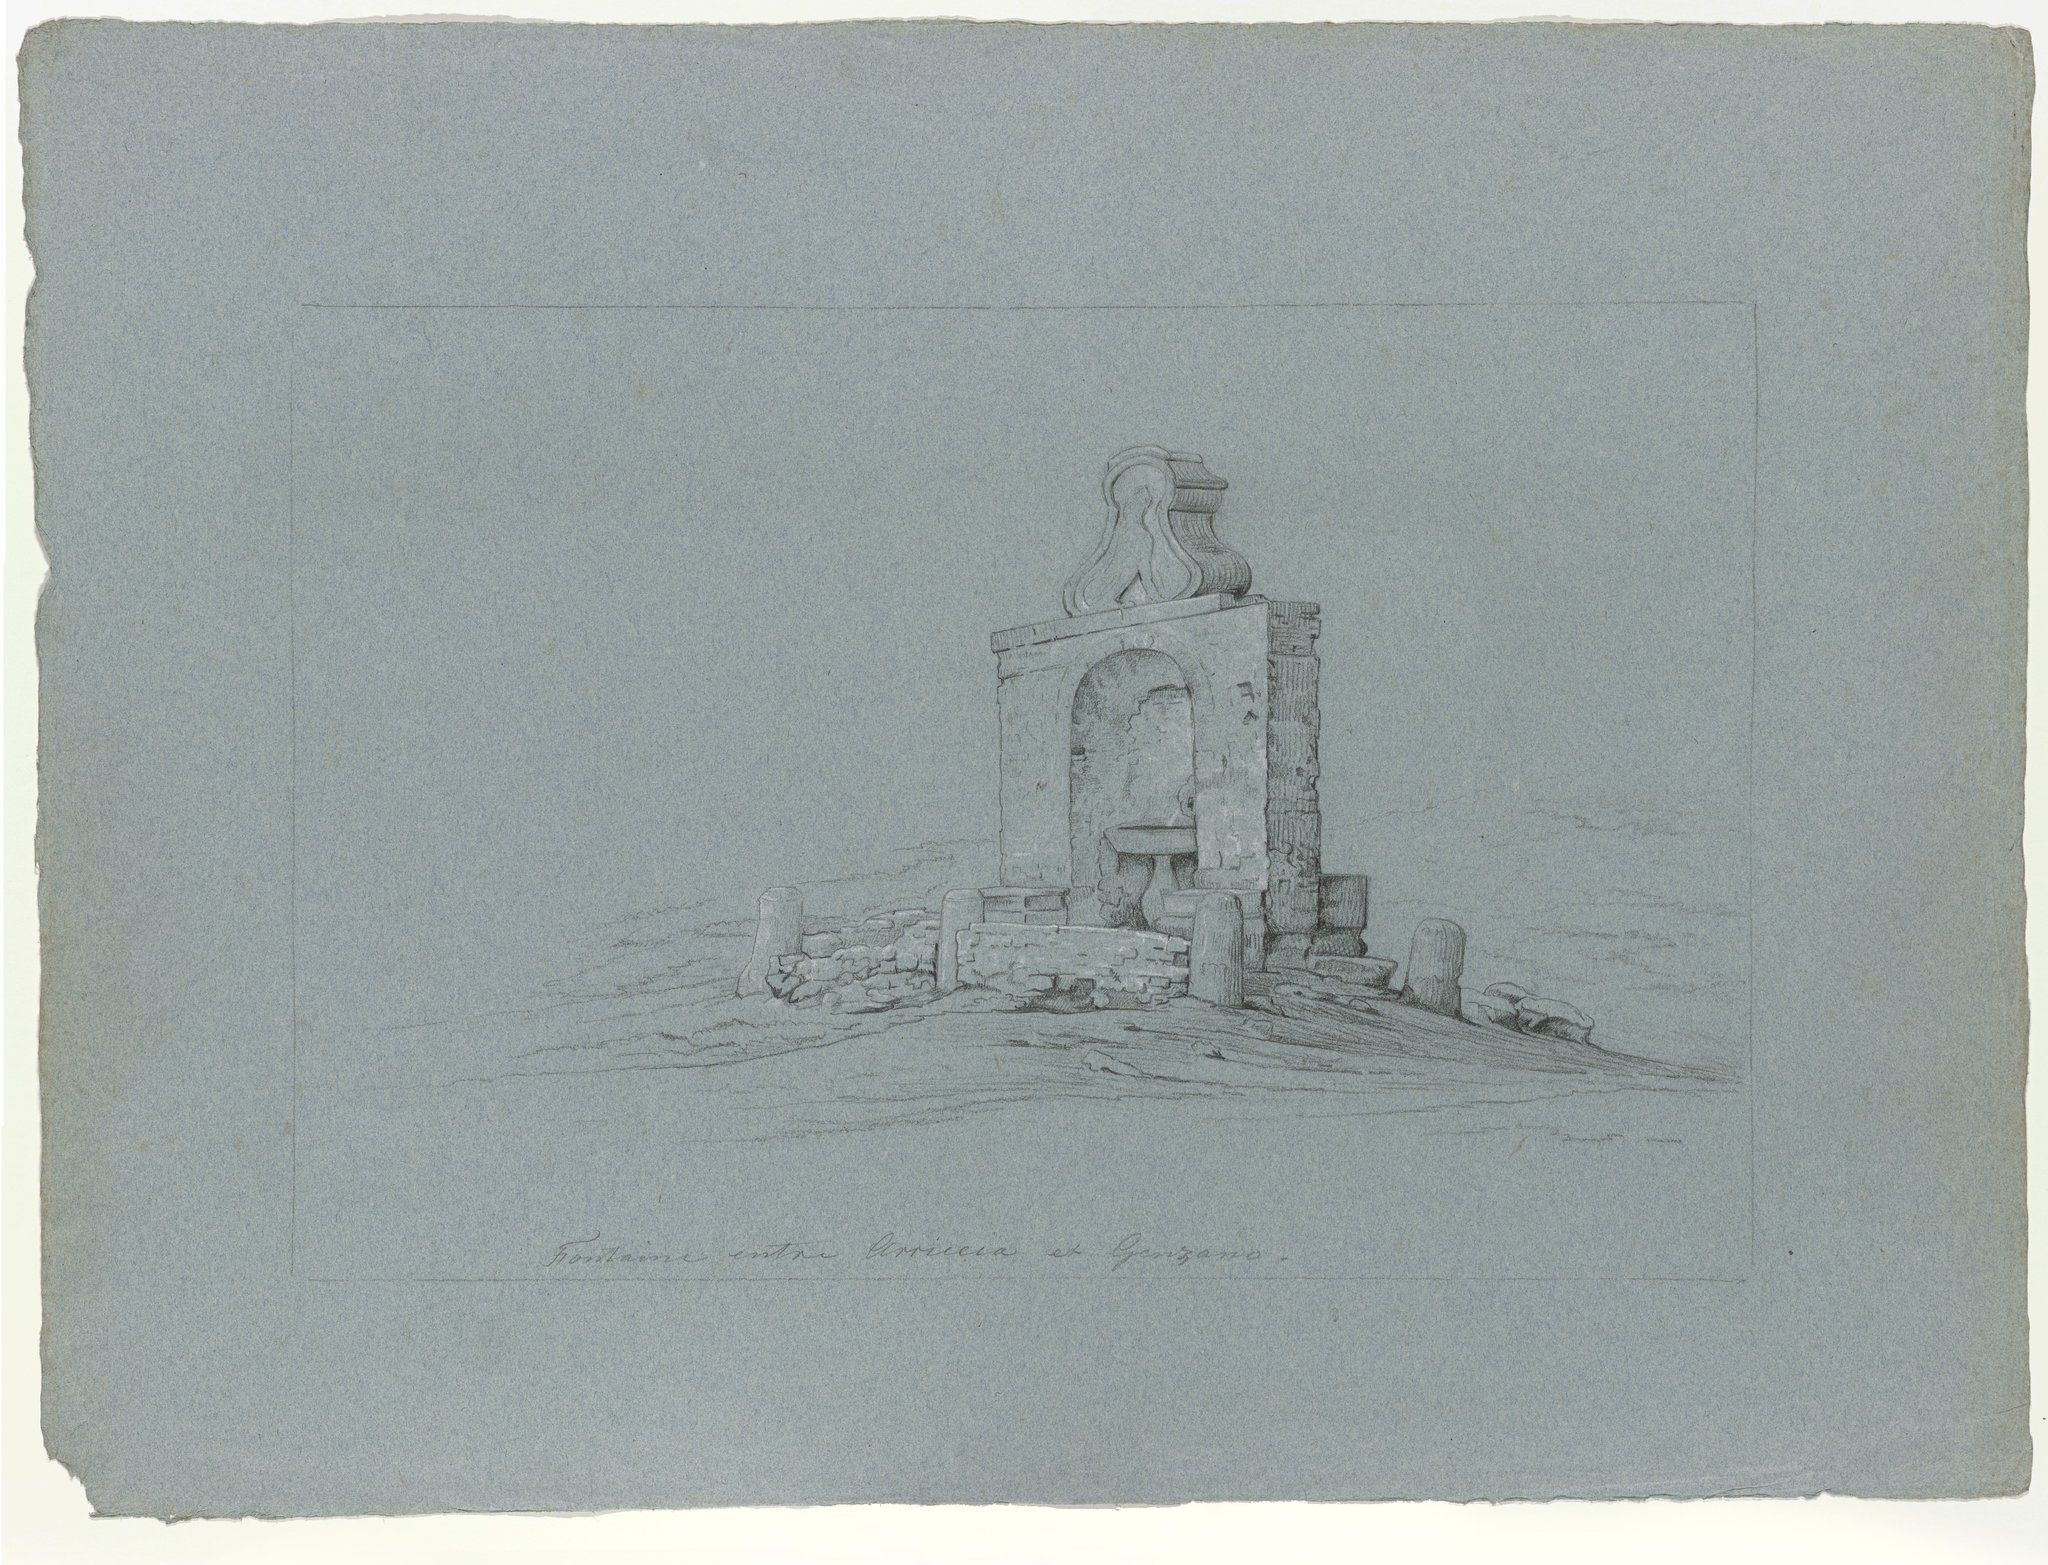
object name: drawing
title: Een fontein tussen Ariccio en Genzano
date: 1786-1857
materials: chalk, paint, paper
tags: well, utilitarian, public pump or water fountain, italy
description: Tekening uit een groep tekeningen van landschappen en stadsgezichten in Italië (Rome, Tivoli, Civita Castellana en Pozzuoli).